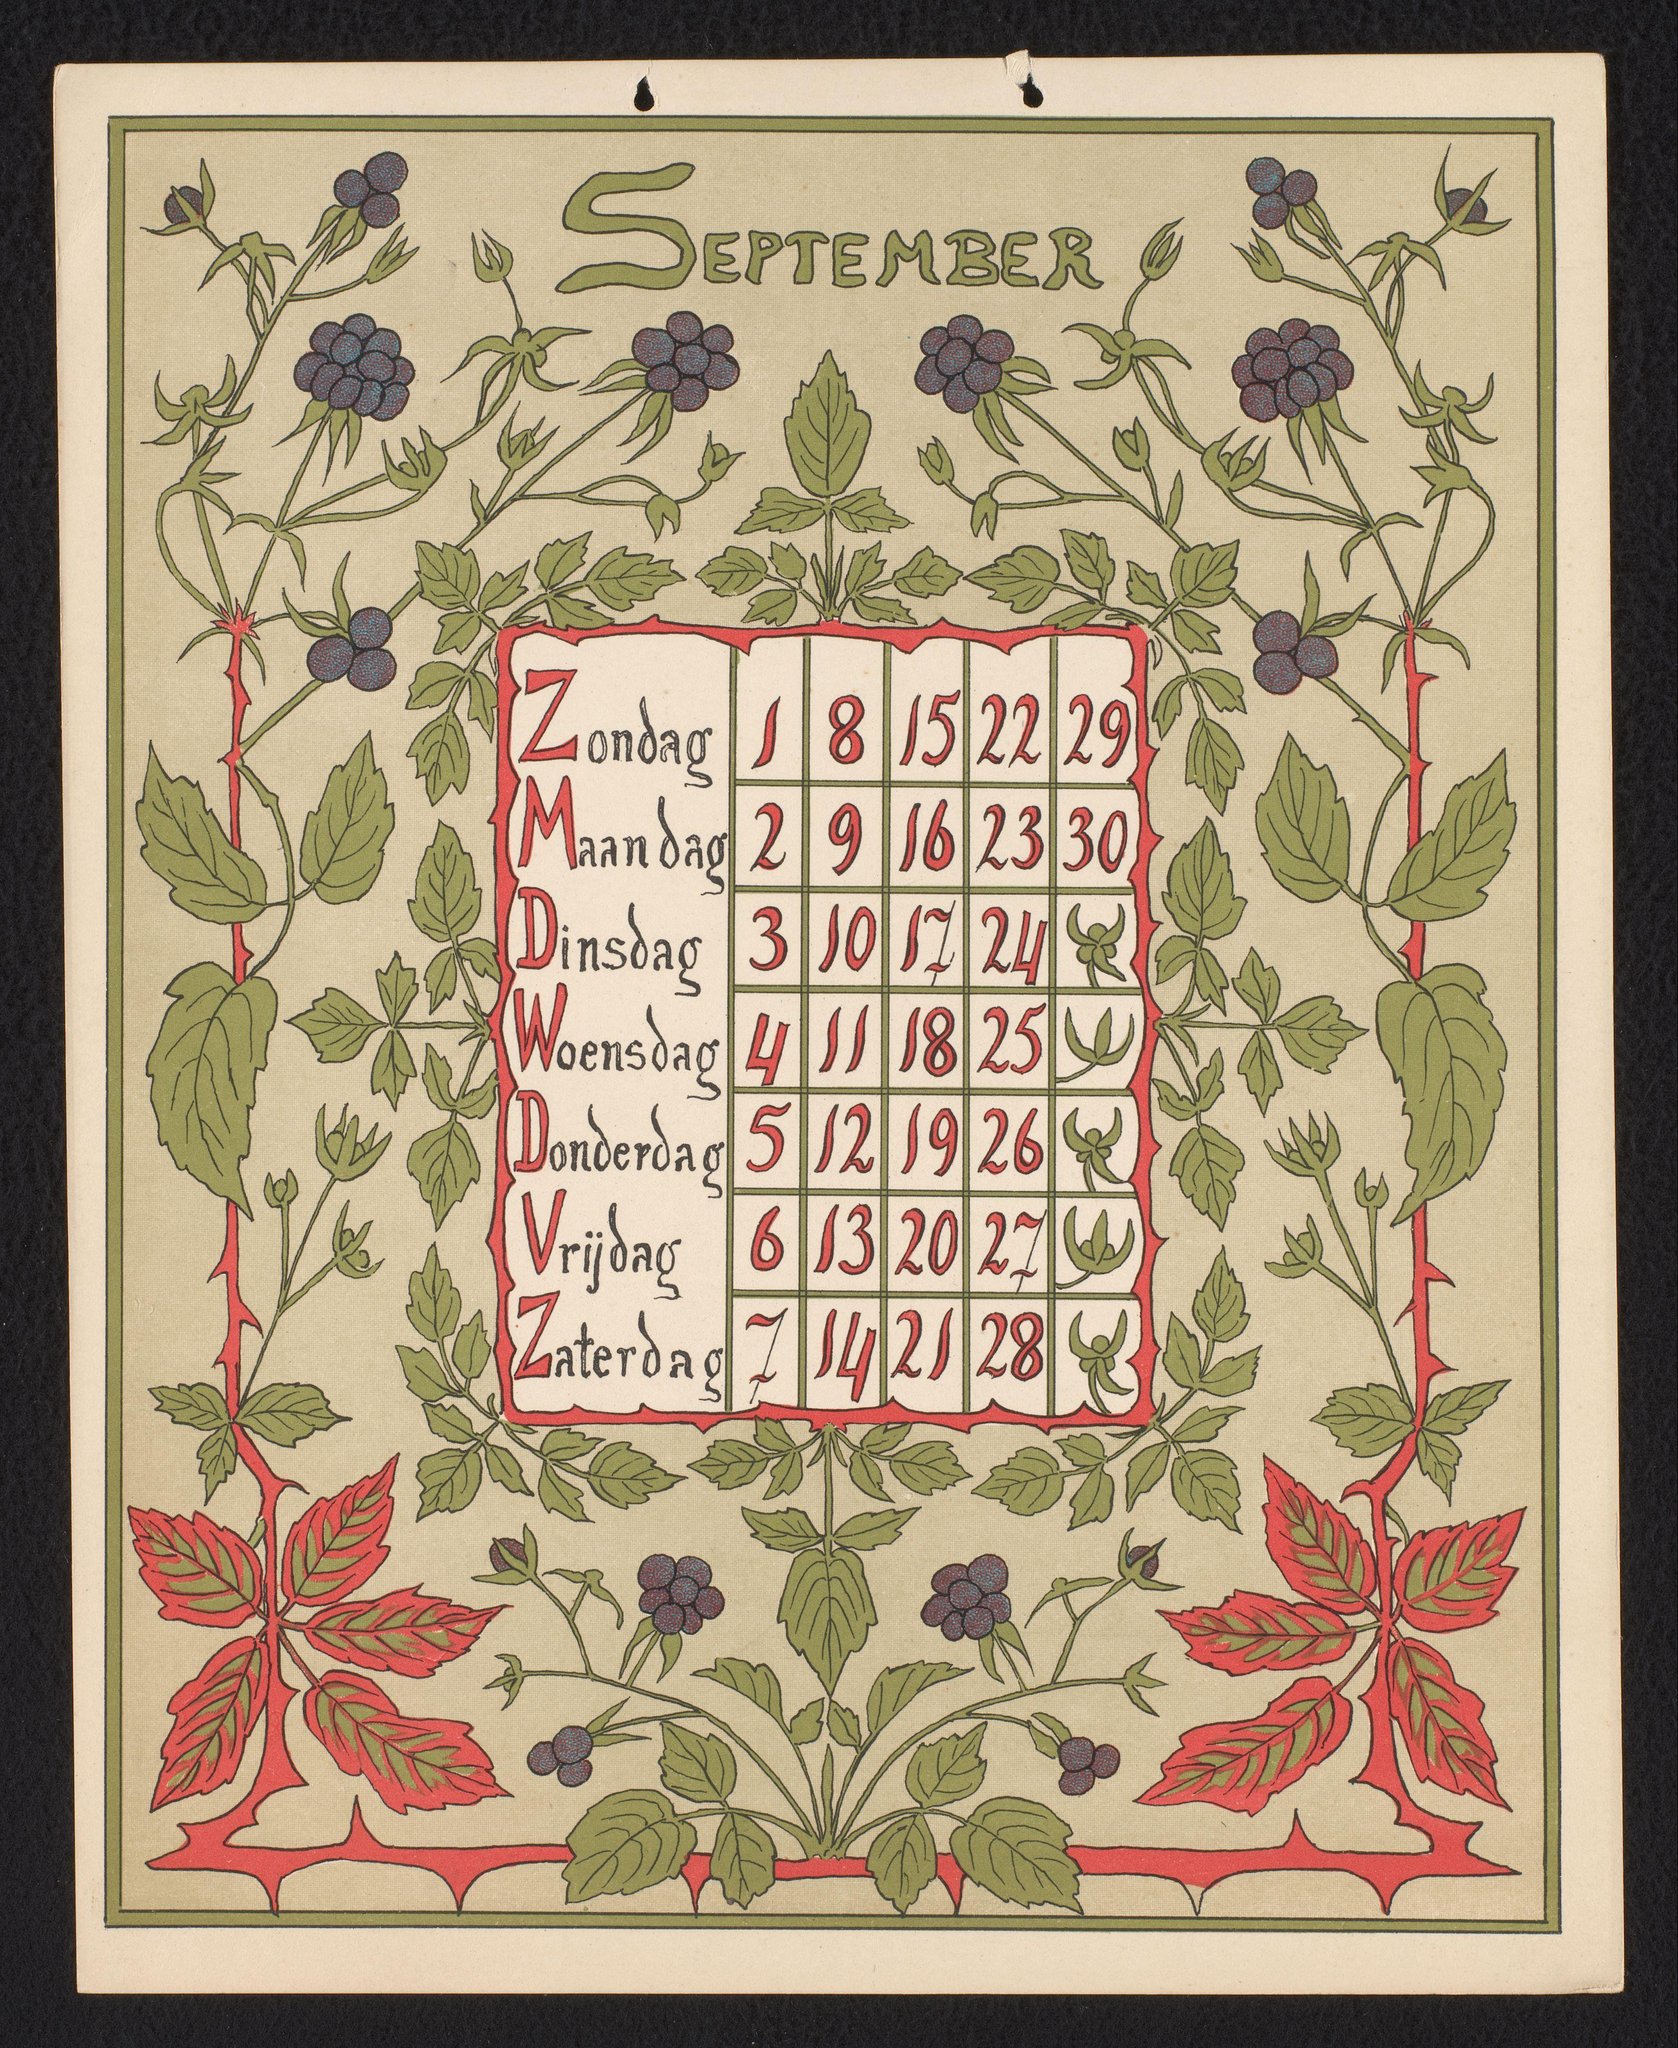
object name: calendar leaf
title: Kalenderblad voor september 1901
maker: c.a.j. van dishoeck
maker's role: publisher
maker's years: 1863-1931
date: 1900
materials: paper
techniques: lithograph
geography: amsterdam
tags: ornaments ~ art, calendar, almanac, fruits: raspberry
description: Kalenderblad voor september 1901 van de kalender 'Bloem en Blad', met een randdecoratie van bramen.